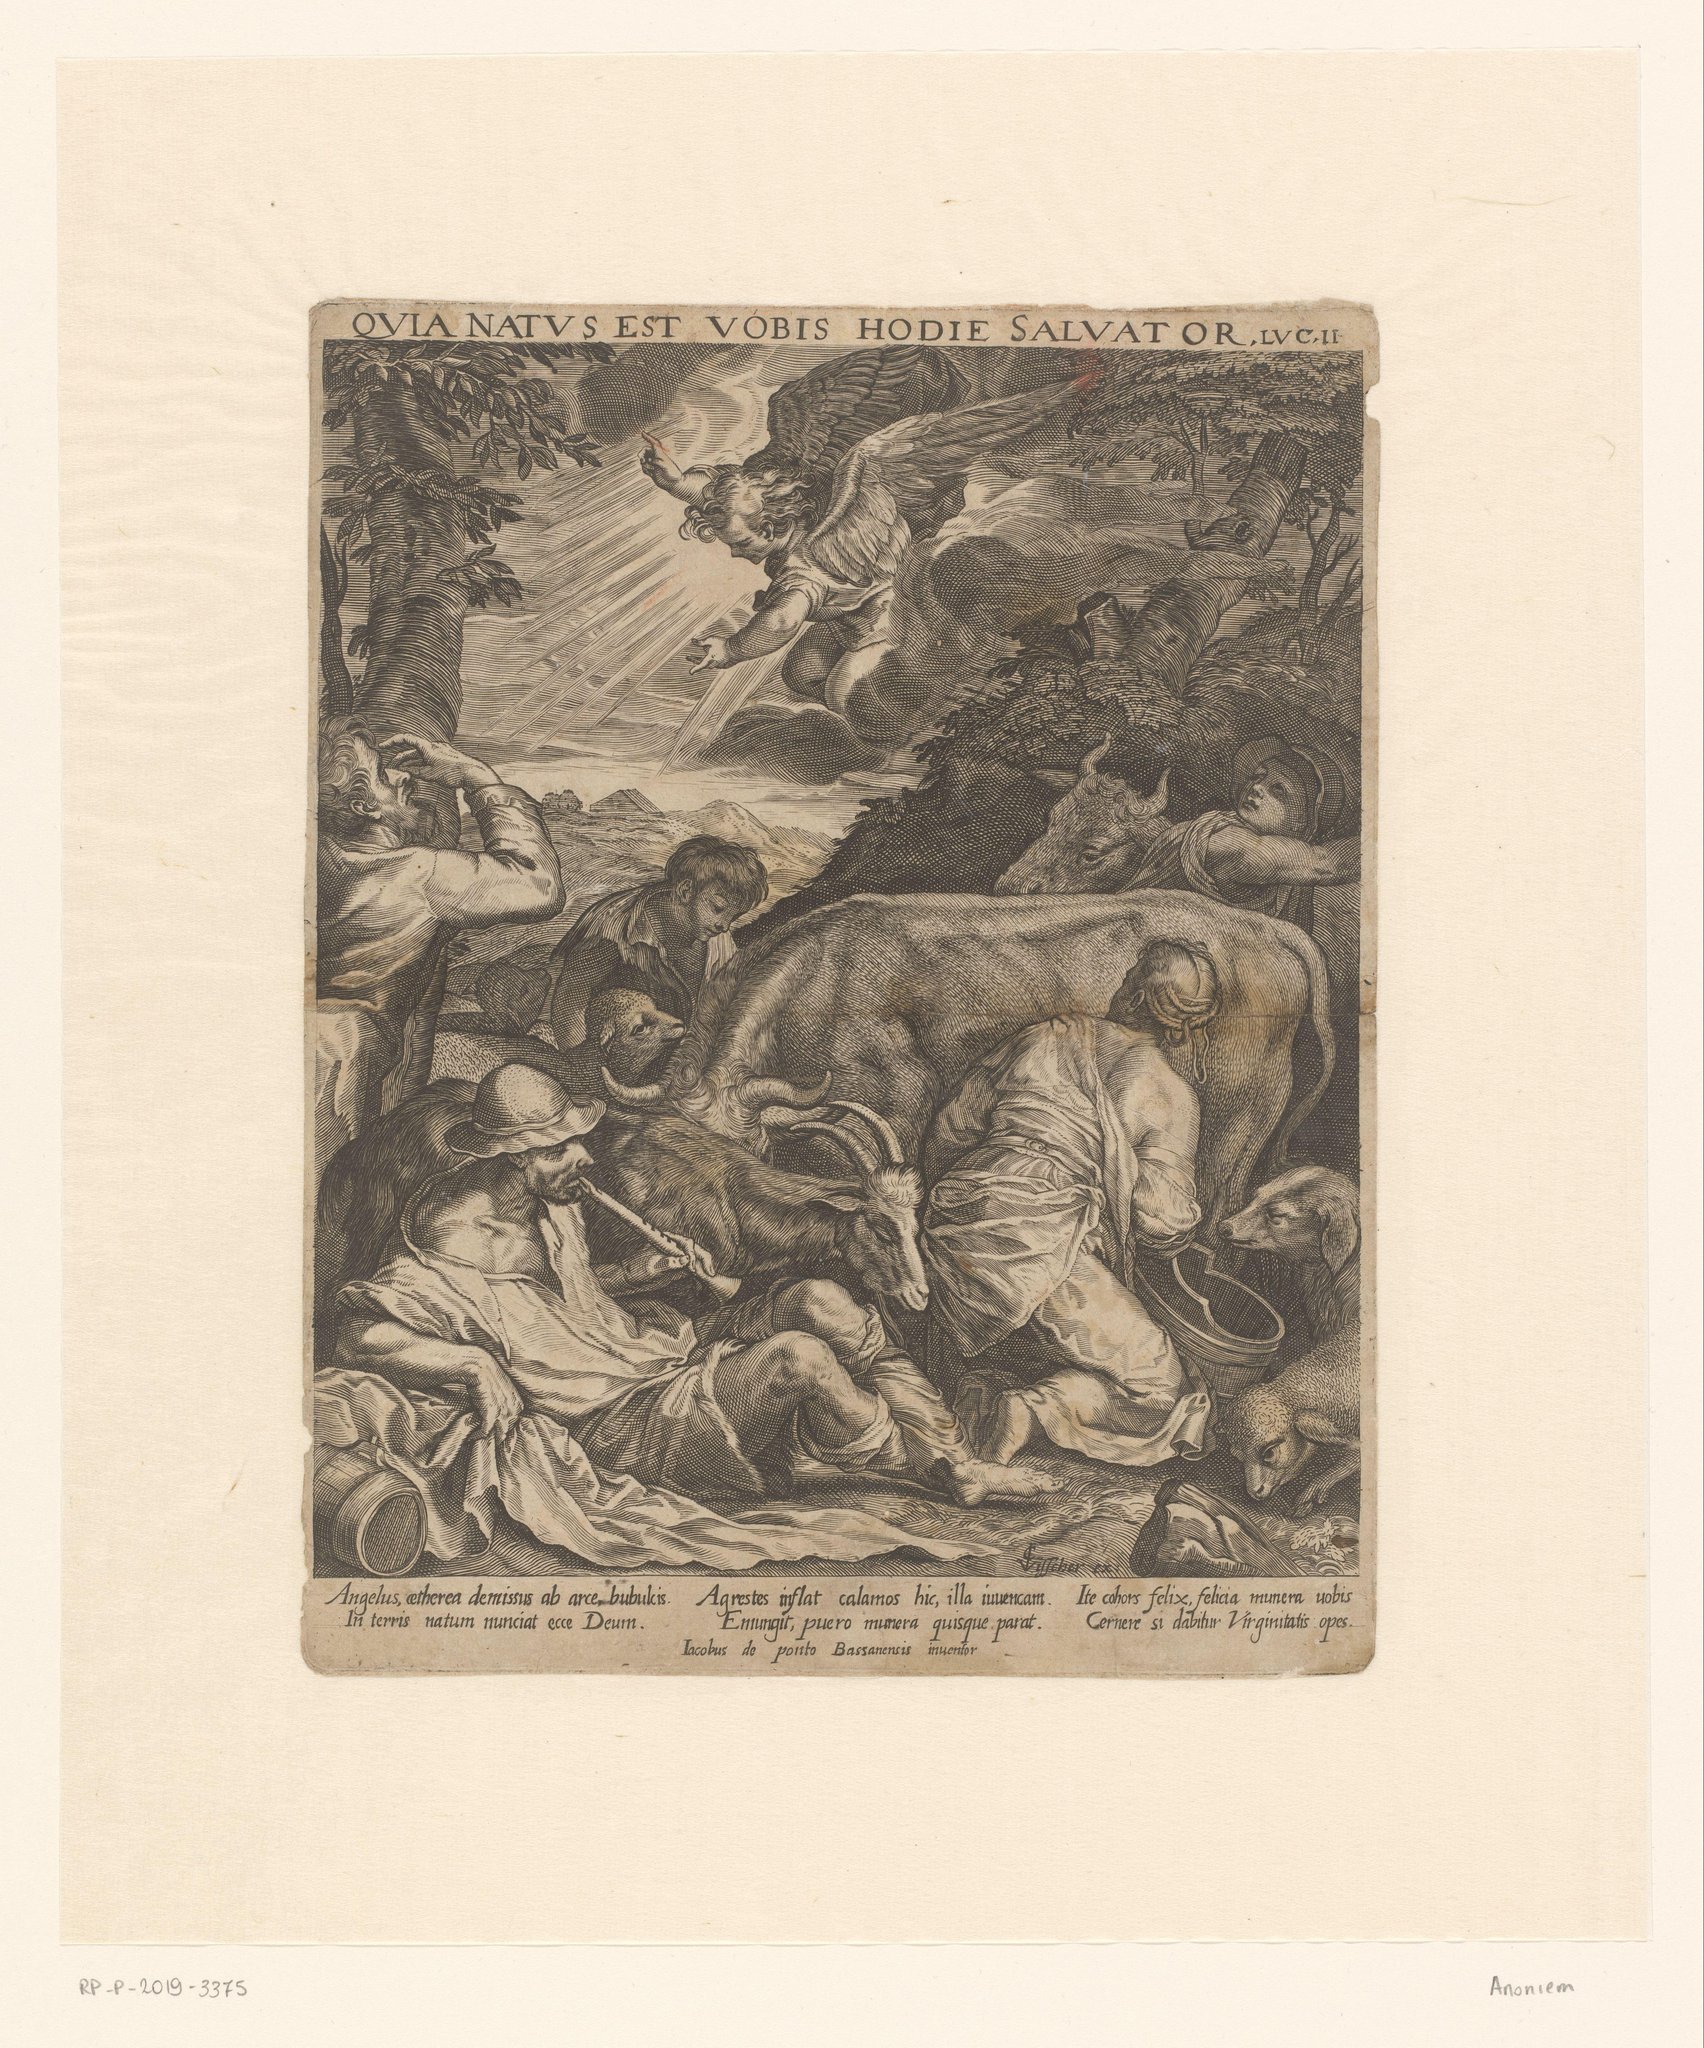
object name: print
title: Abraham vertrekt naar Sichem en verkondiging aan de herders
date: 1596-1652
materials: paper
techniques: engraving, etching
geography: netherlands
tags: abraham comes to the sacred tree of moreh at shechem, and builds his first altar, annunciation of christ's birth to the shepherds (and/or shepherdesses) at night; a host of singing angels in the air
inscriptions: collector's mark: Lugt 2228